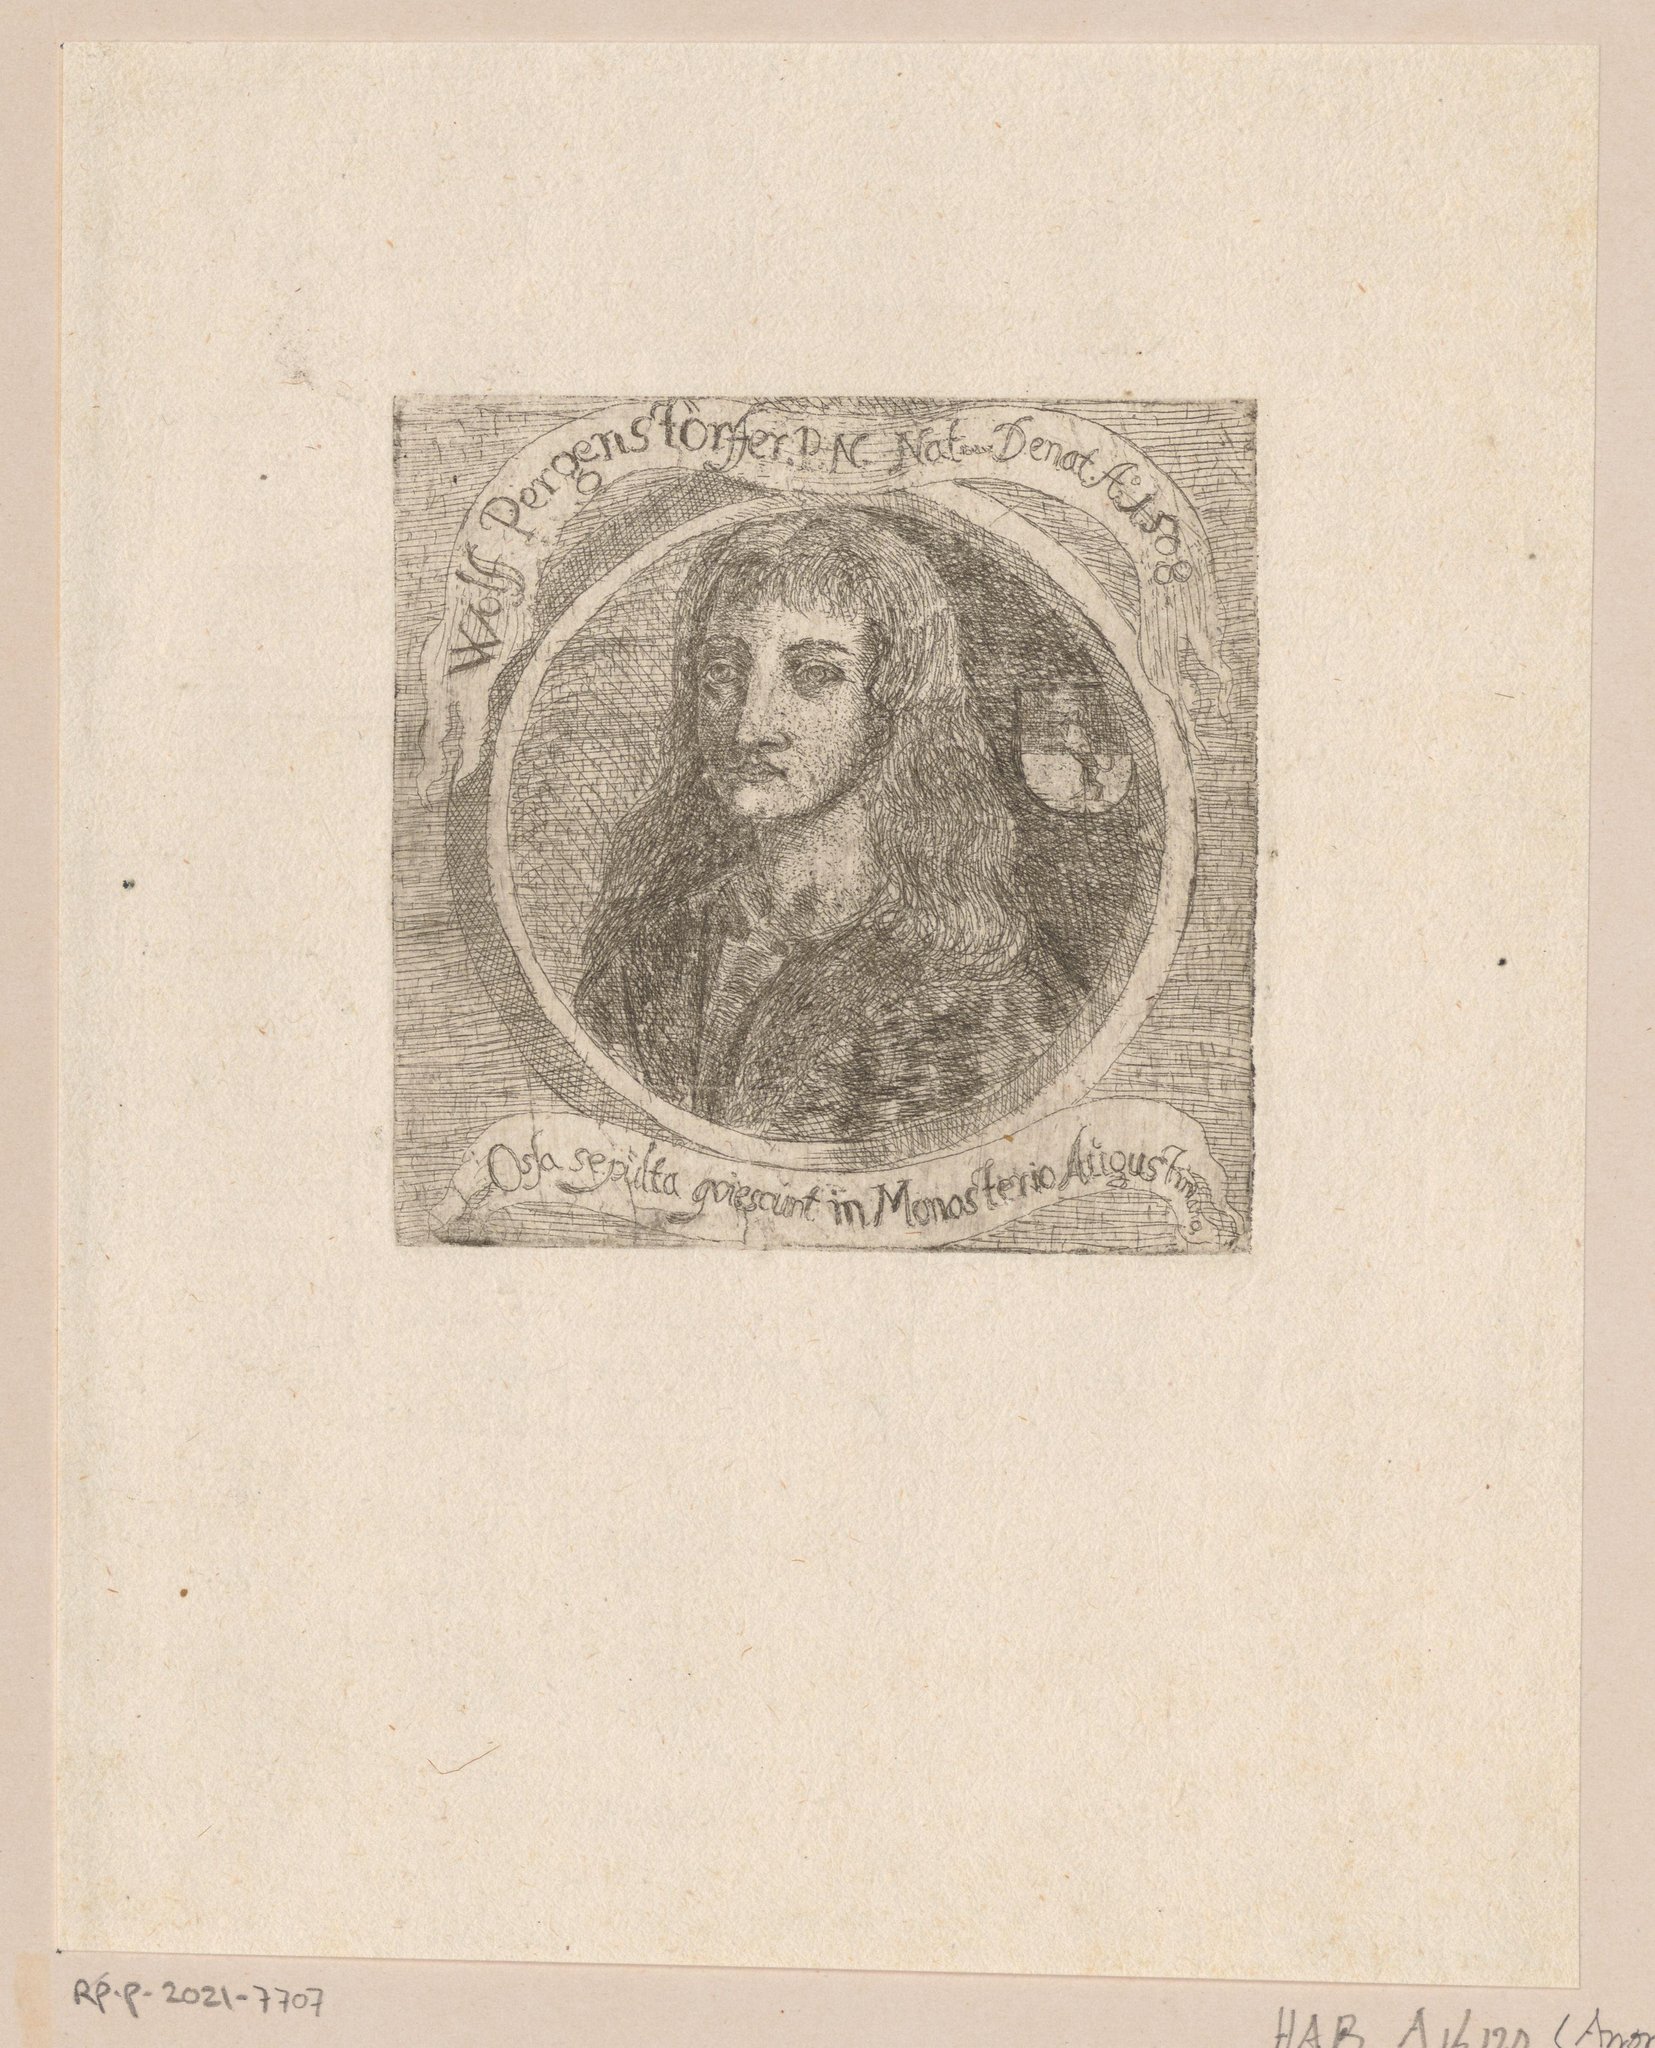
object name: print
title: Portret van Wolff Pergenstörffer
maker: Anonymous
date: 1600-1699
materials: paper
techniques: etching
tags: adult man, historical persons, armorial bearing, heraldry